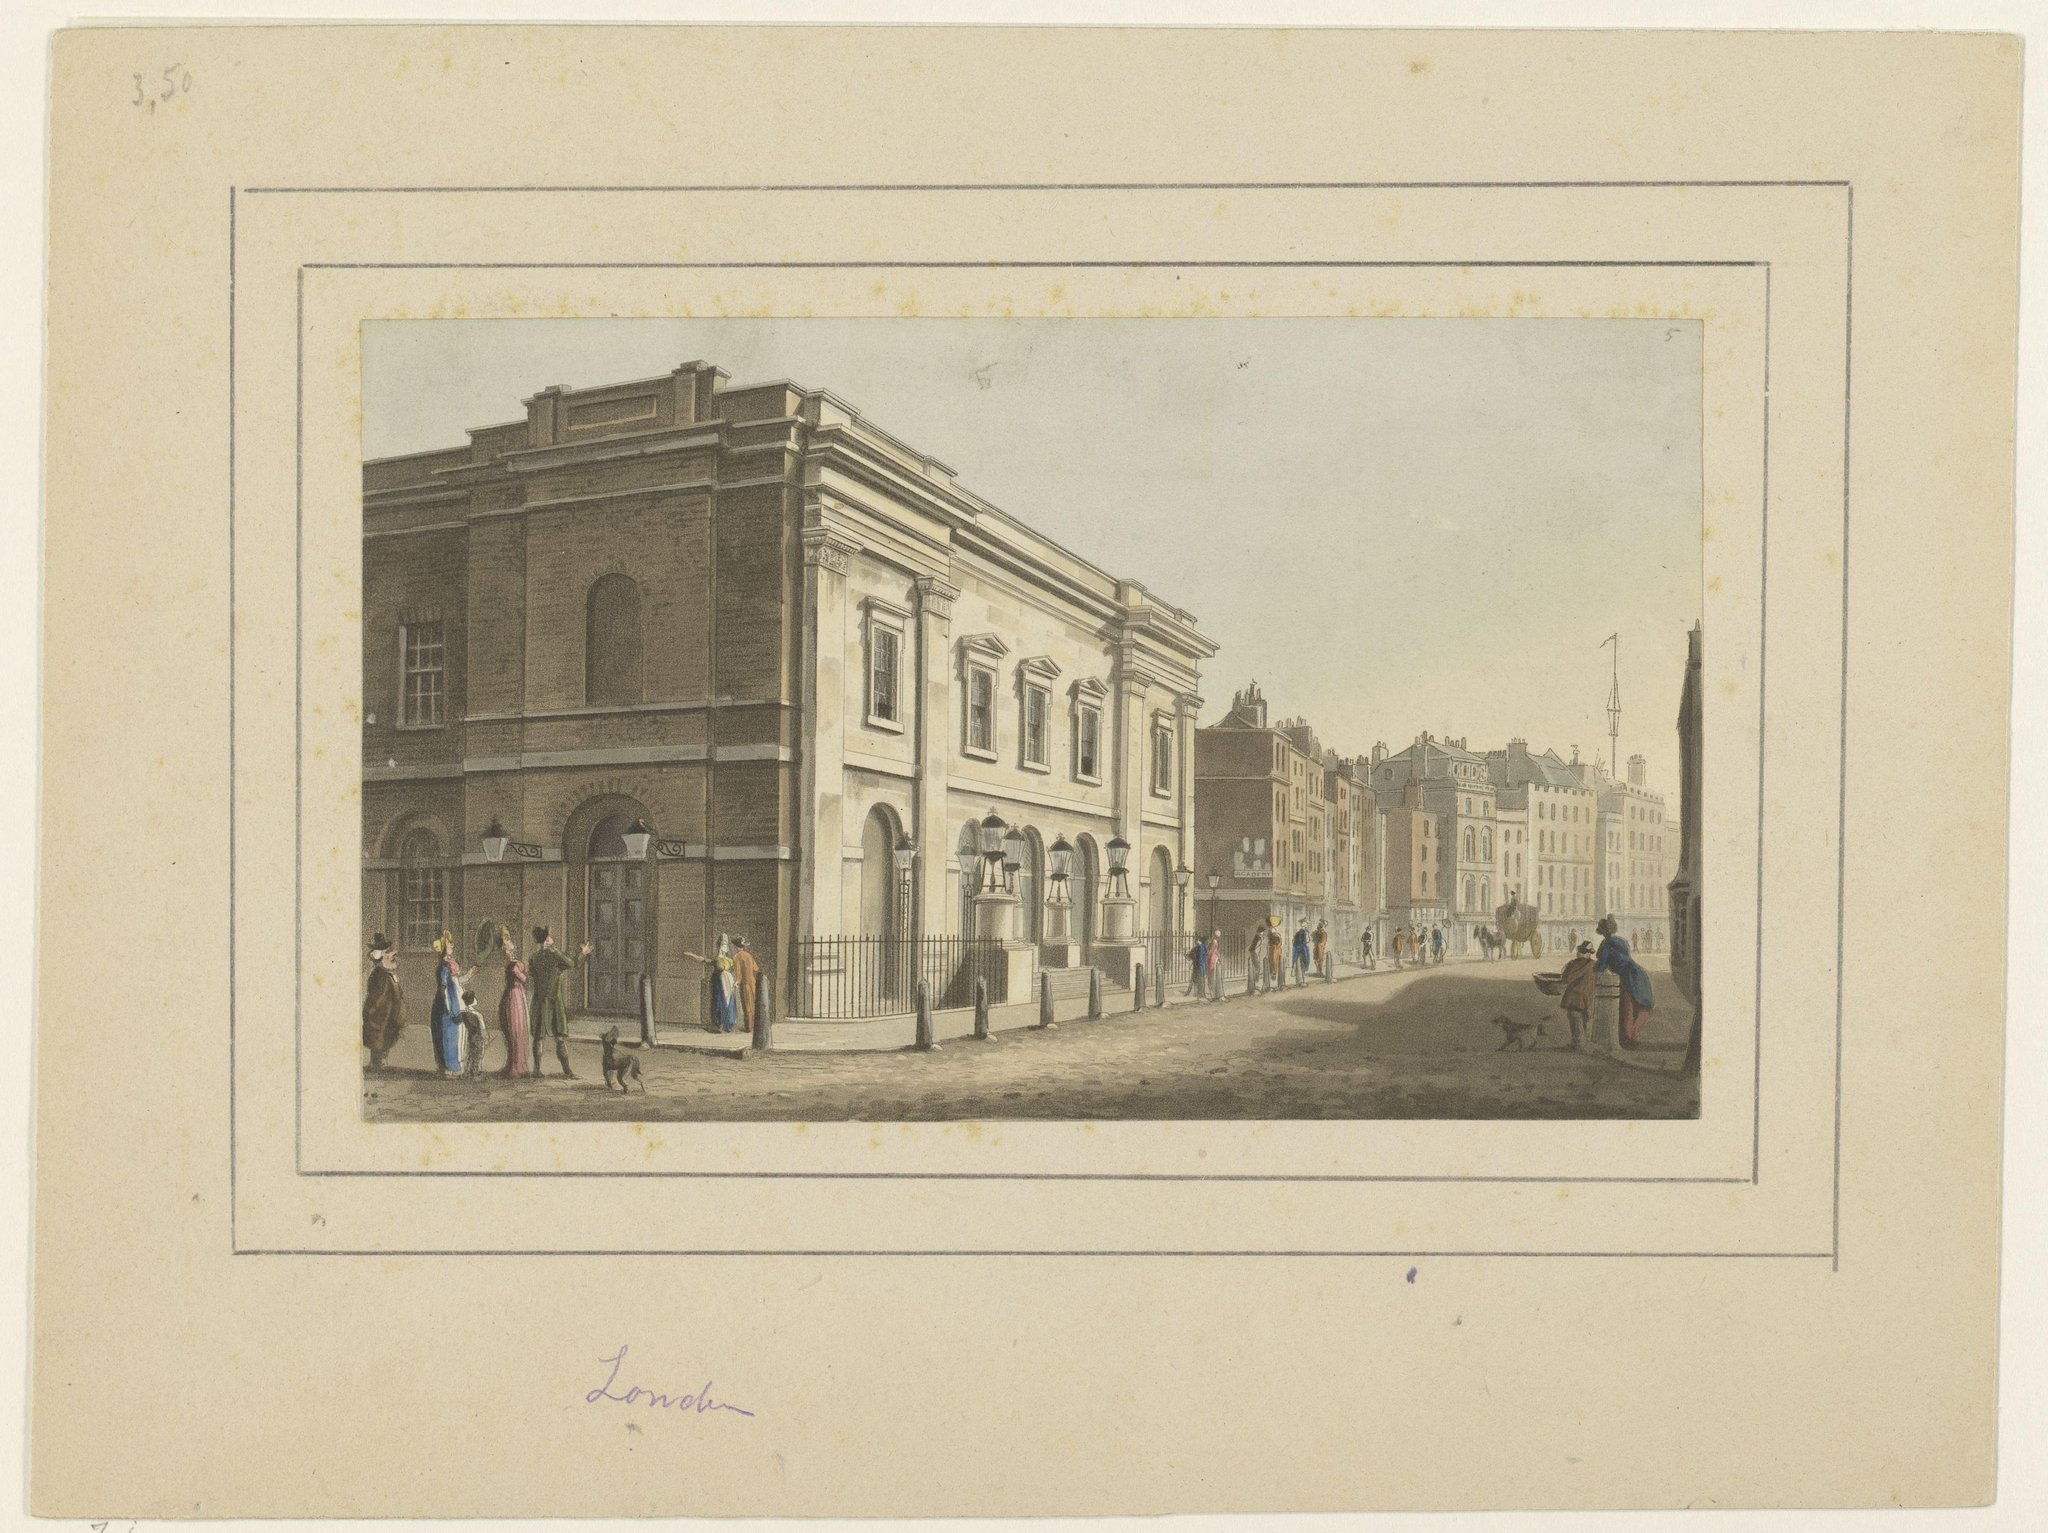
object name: print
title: Gezicht op een straat te Londen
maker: Anonymous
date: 1800-1899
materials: paper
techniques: aquatint, etching, hand coloring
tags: street, london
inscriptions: collector's mark: Lugt 2228